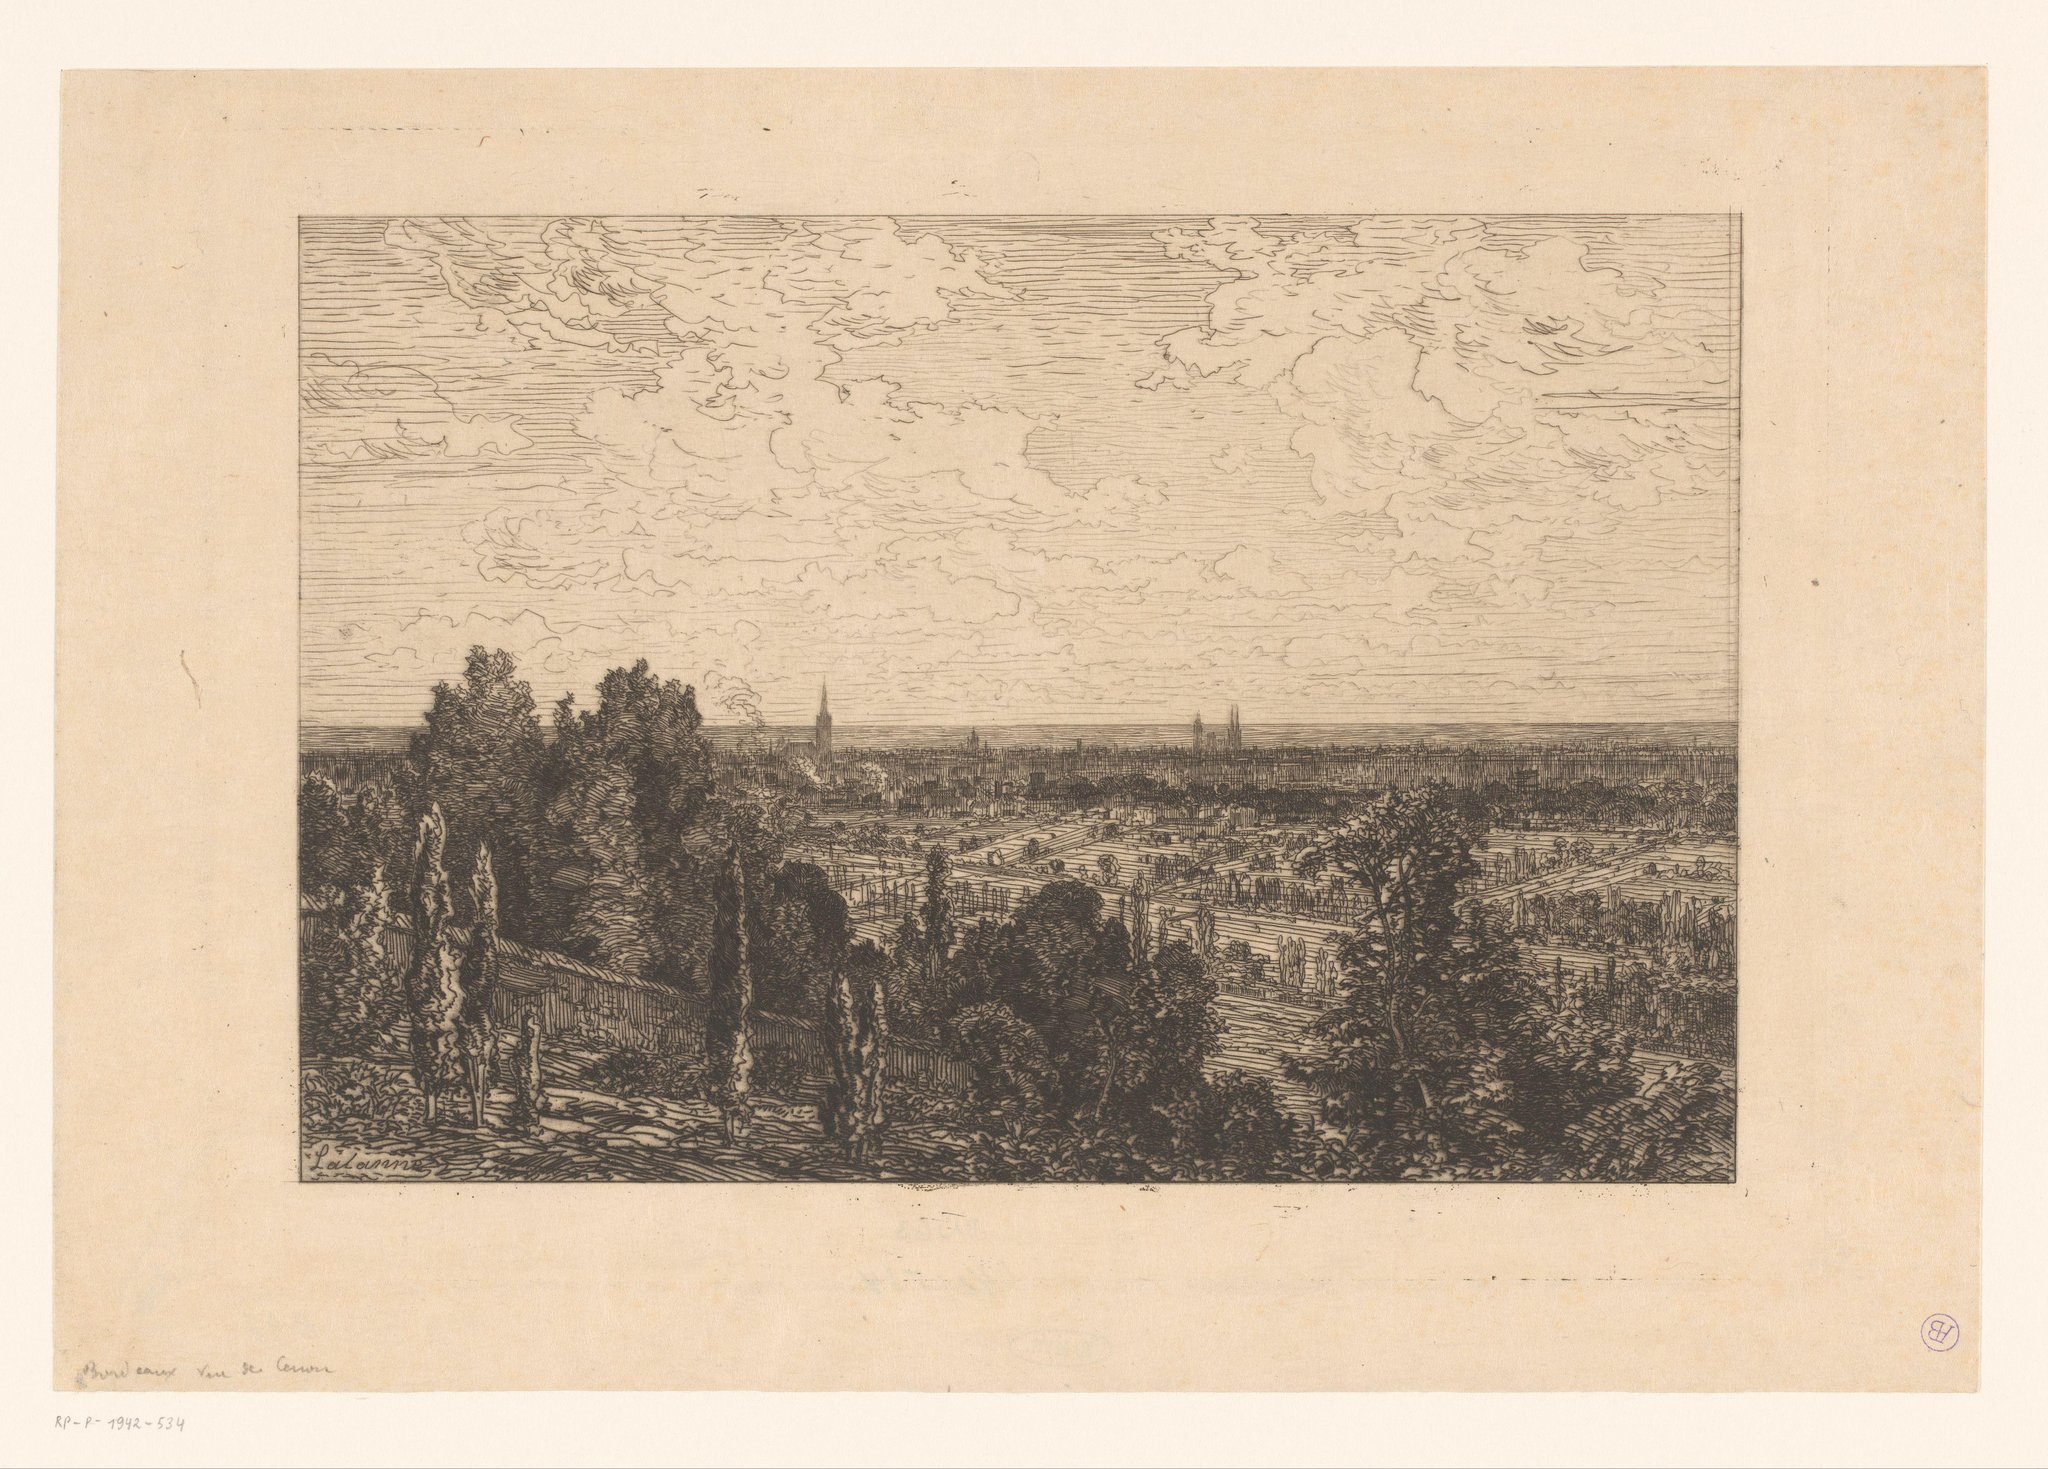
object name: print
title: Gezicht op Cenon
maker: maxime françois antoine lalanne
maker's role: draughtsman, print maker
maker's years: 1827-1886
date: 1879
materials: paper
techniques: drypoint, engraving, etching, intaglio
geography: france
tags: city-view, and landscape with man-made constructions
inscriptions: collector's mark: Lugt 2228, collector's mark: Lugt 76, title: ‘Bordeaux Vue de Cenon’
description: Gepubliceerd in: L'Illustration nouvelle, 1879.